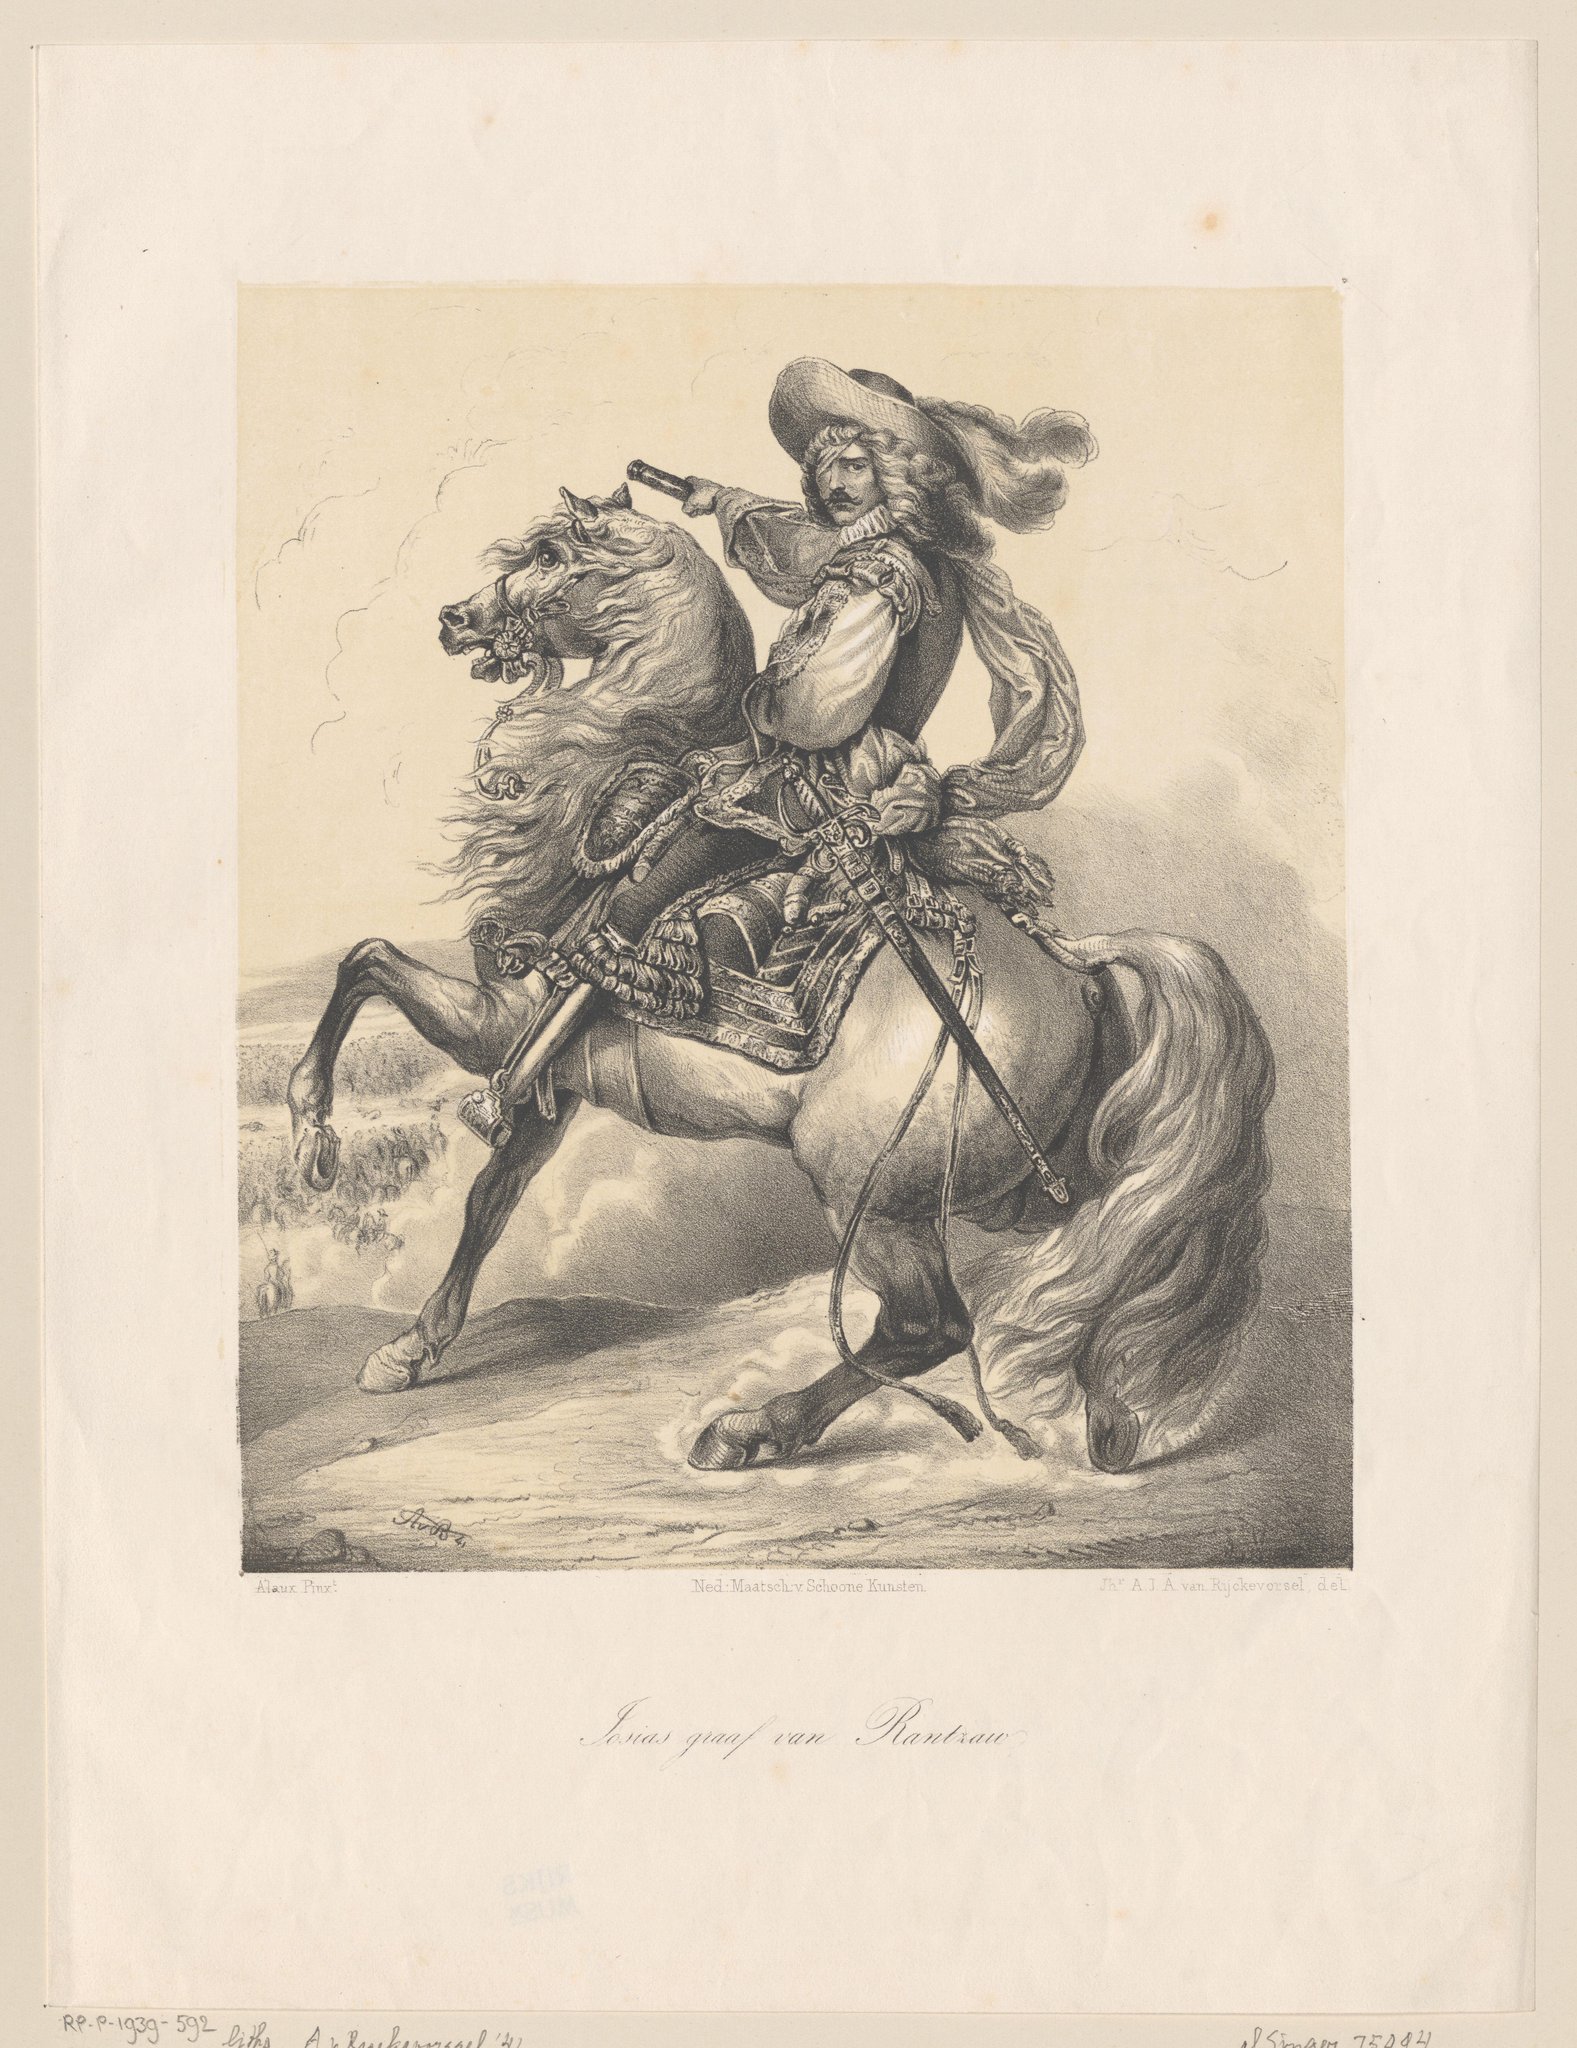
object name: print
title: Portret van Josias von Rantzau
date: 1841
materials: paper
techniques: tone lithography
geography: the hague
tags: equestrian state-portrait, historical persons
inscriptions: collector's mark: Lugt 2166